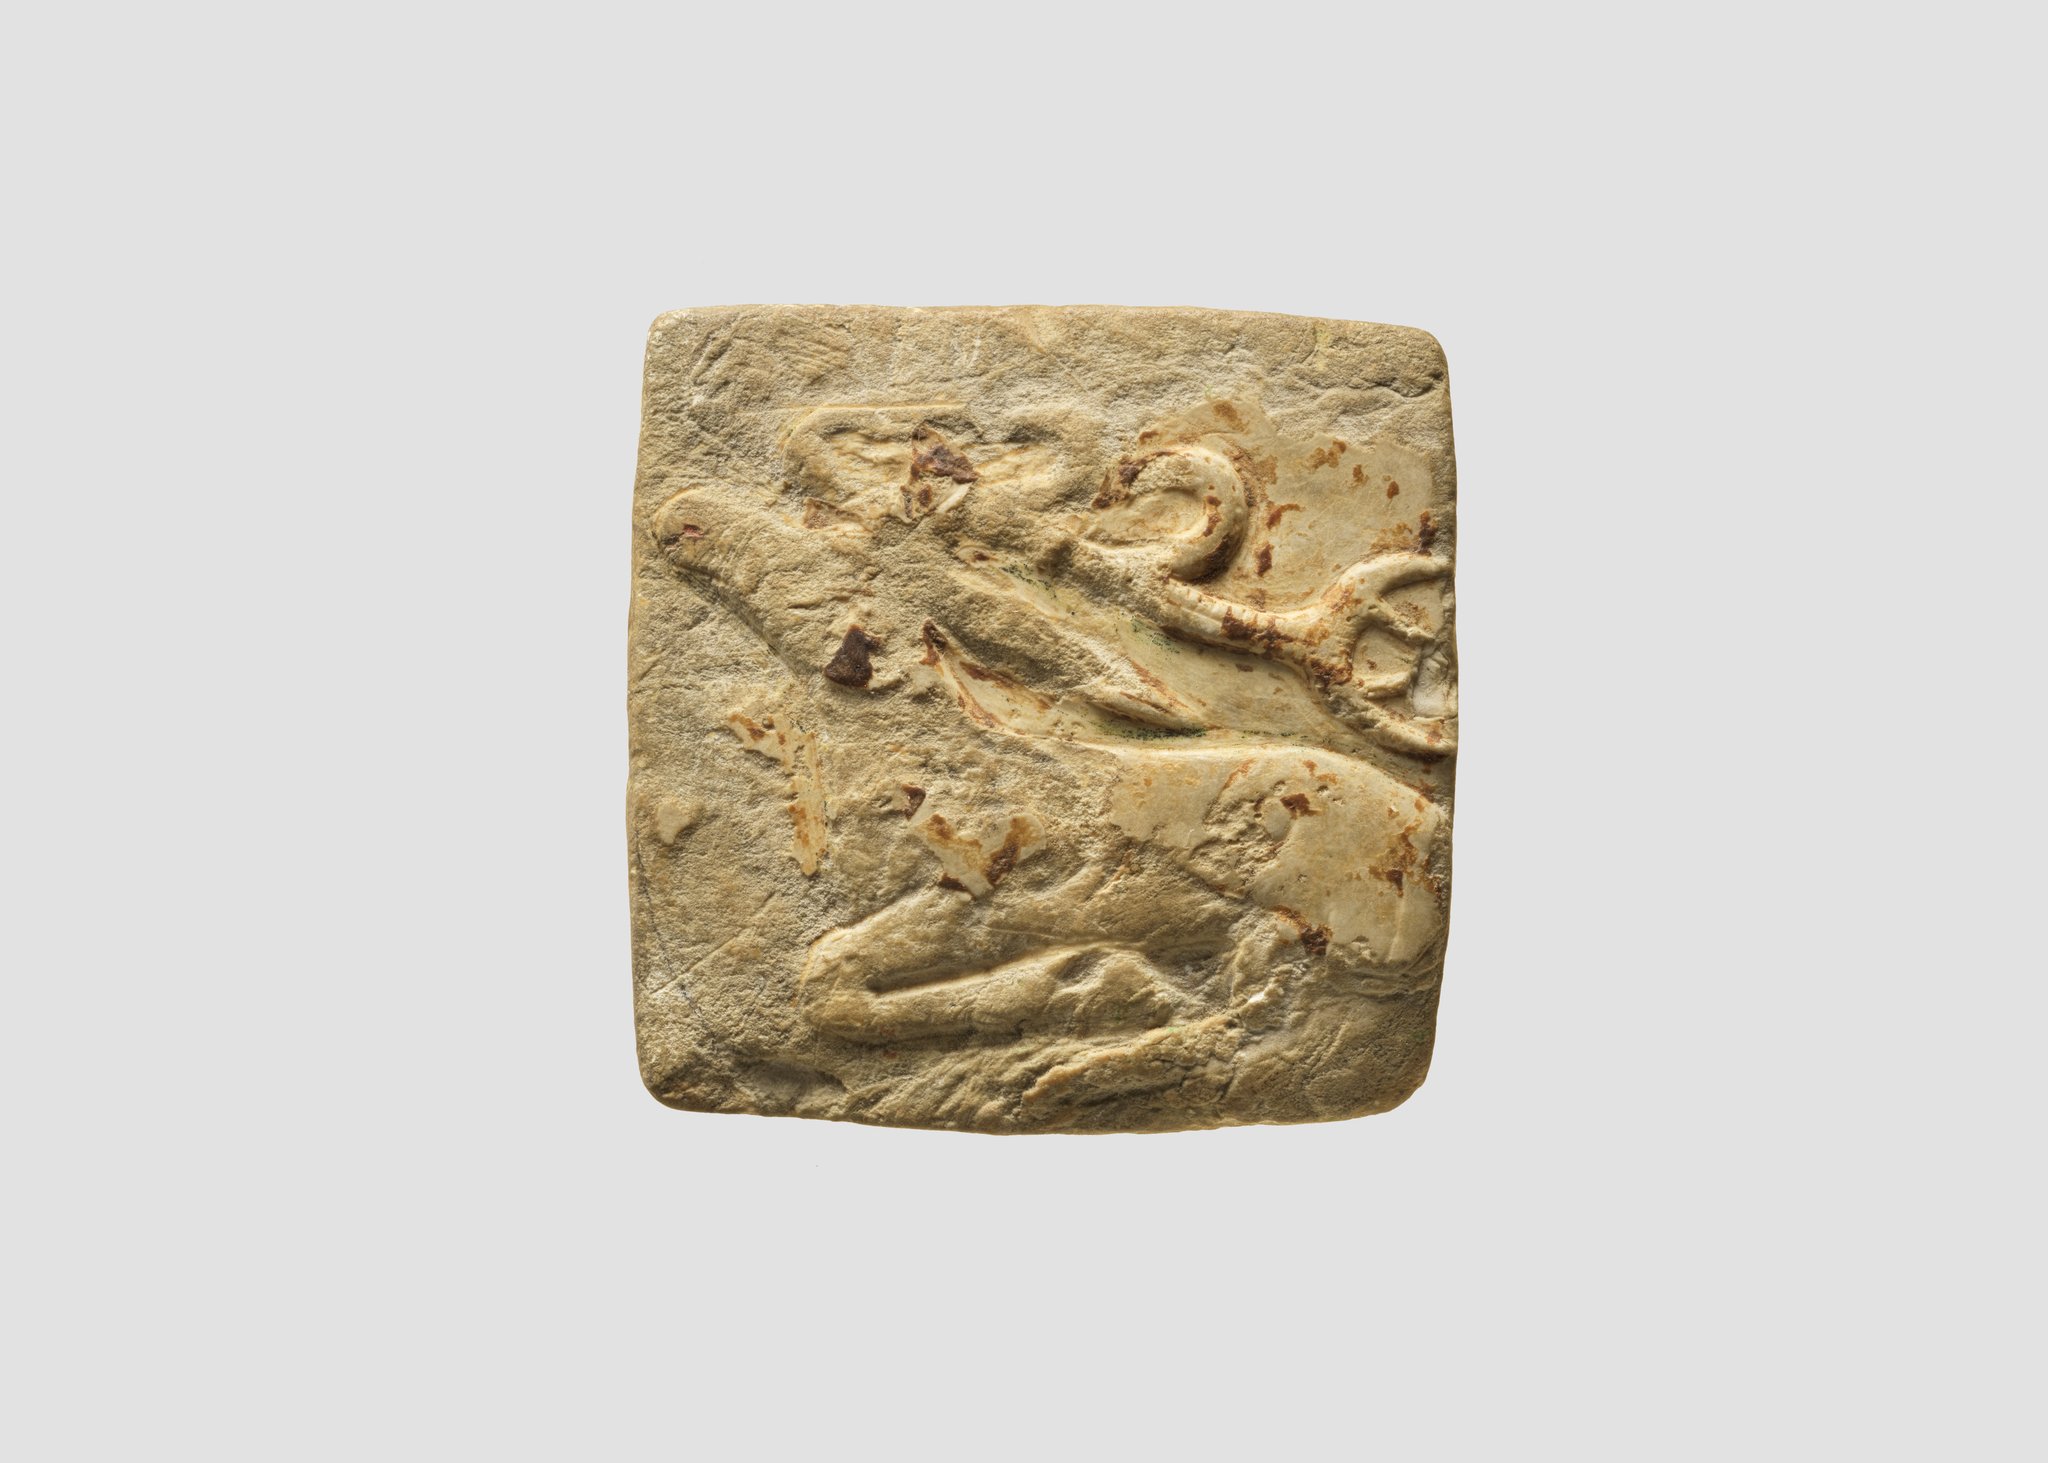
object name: relief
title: Plaque with deer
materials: stone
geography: mesopotamia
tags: deer